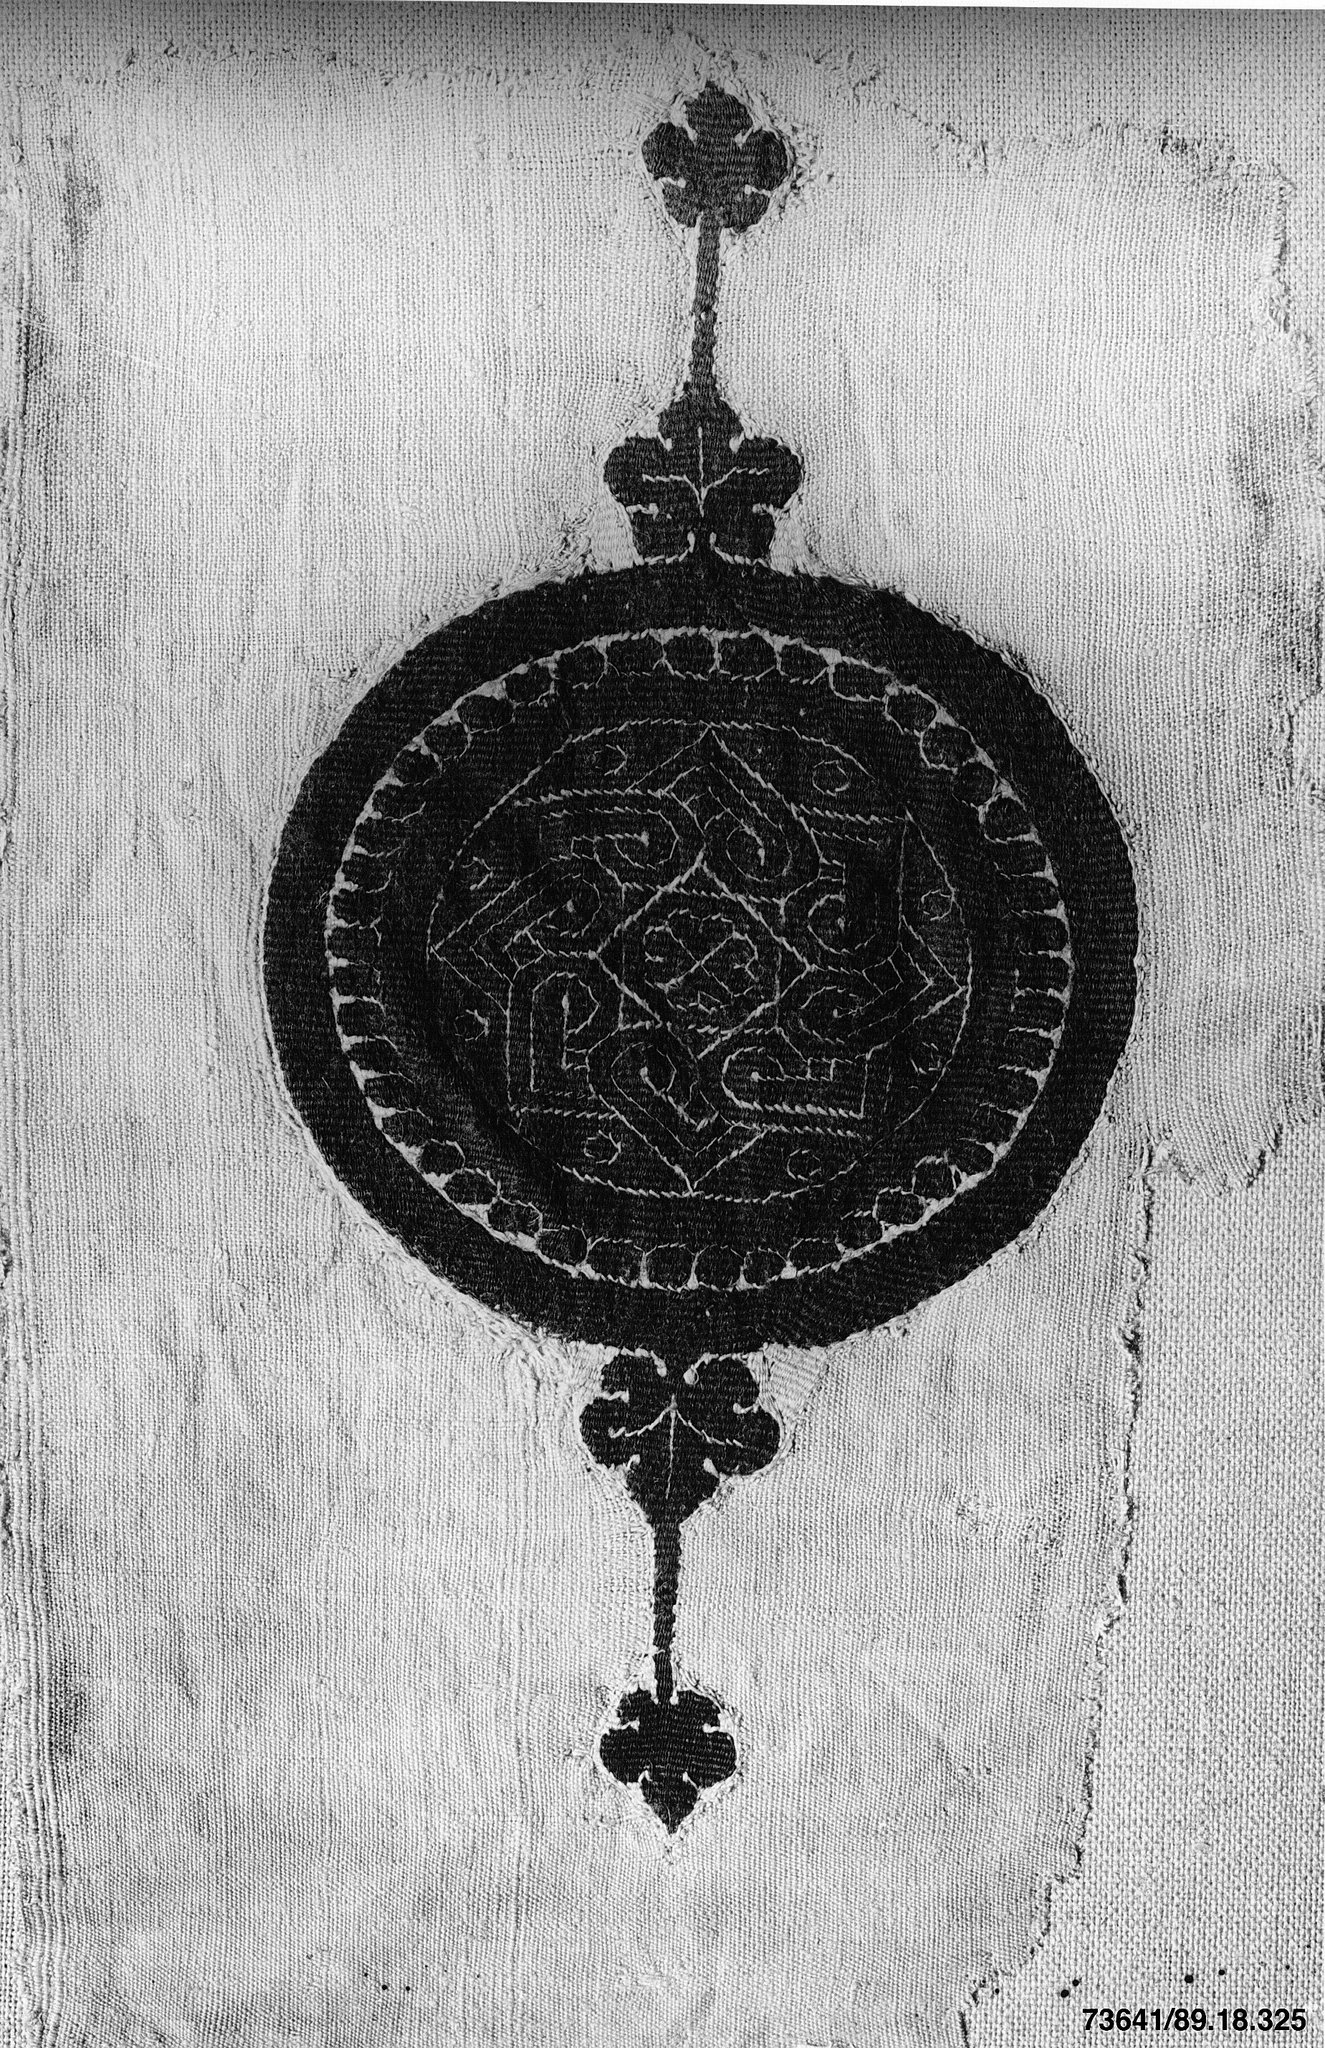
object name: textile fragment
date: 201-400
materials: linen, wool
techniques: weave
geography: egypt